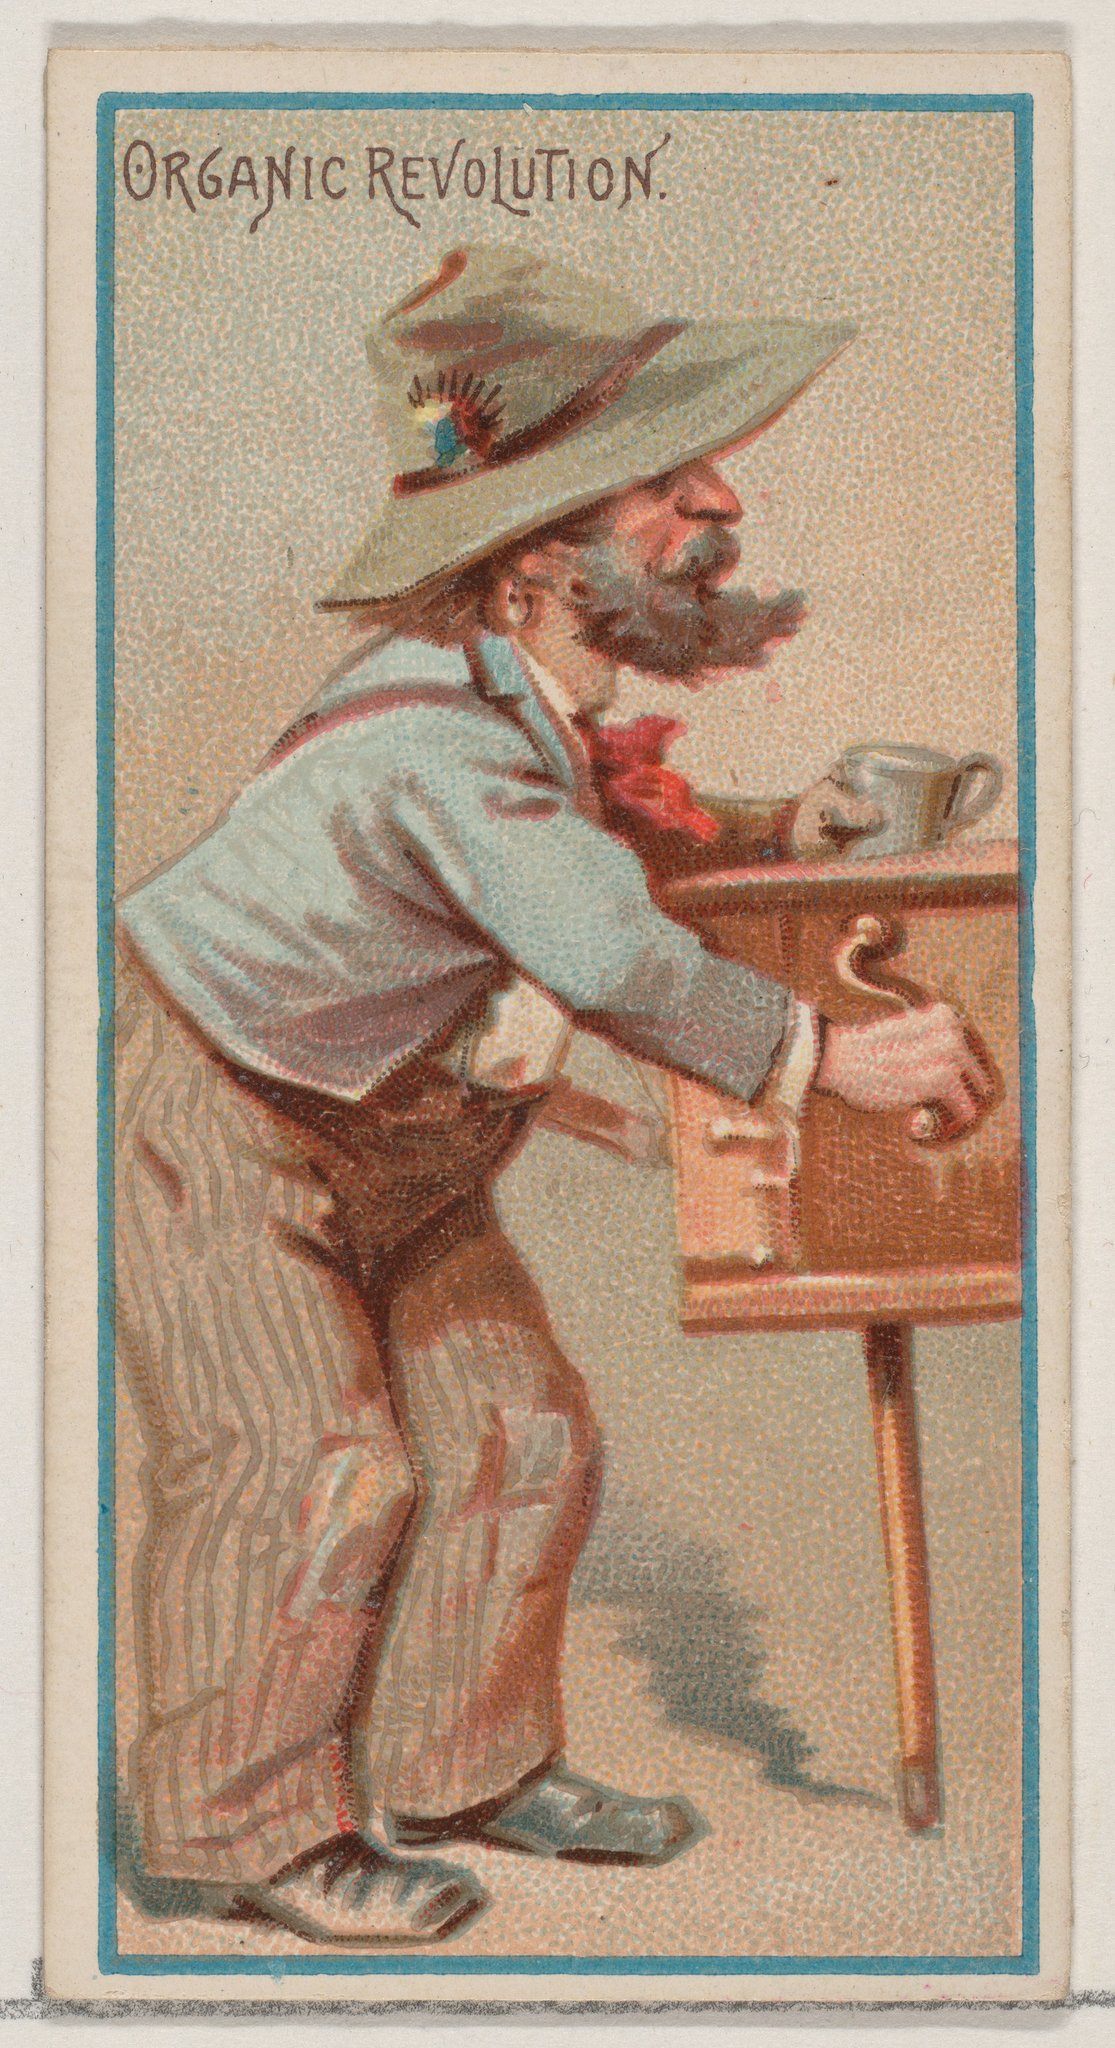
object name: print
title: Organic Revolution, from the Jokes series (N87) for Duke brand cigarettes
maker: w. duke, sons & co.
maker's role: publisher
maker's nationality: american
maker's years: 1870-1920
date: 1890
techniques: color lithograph